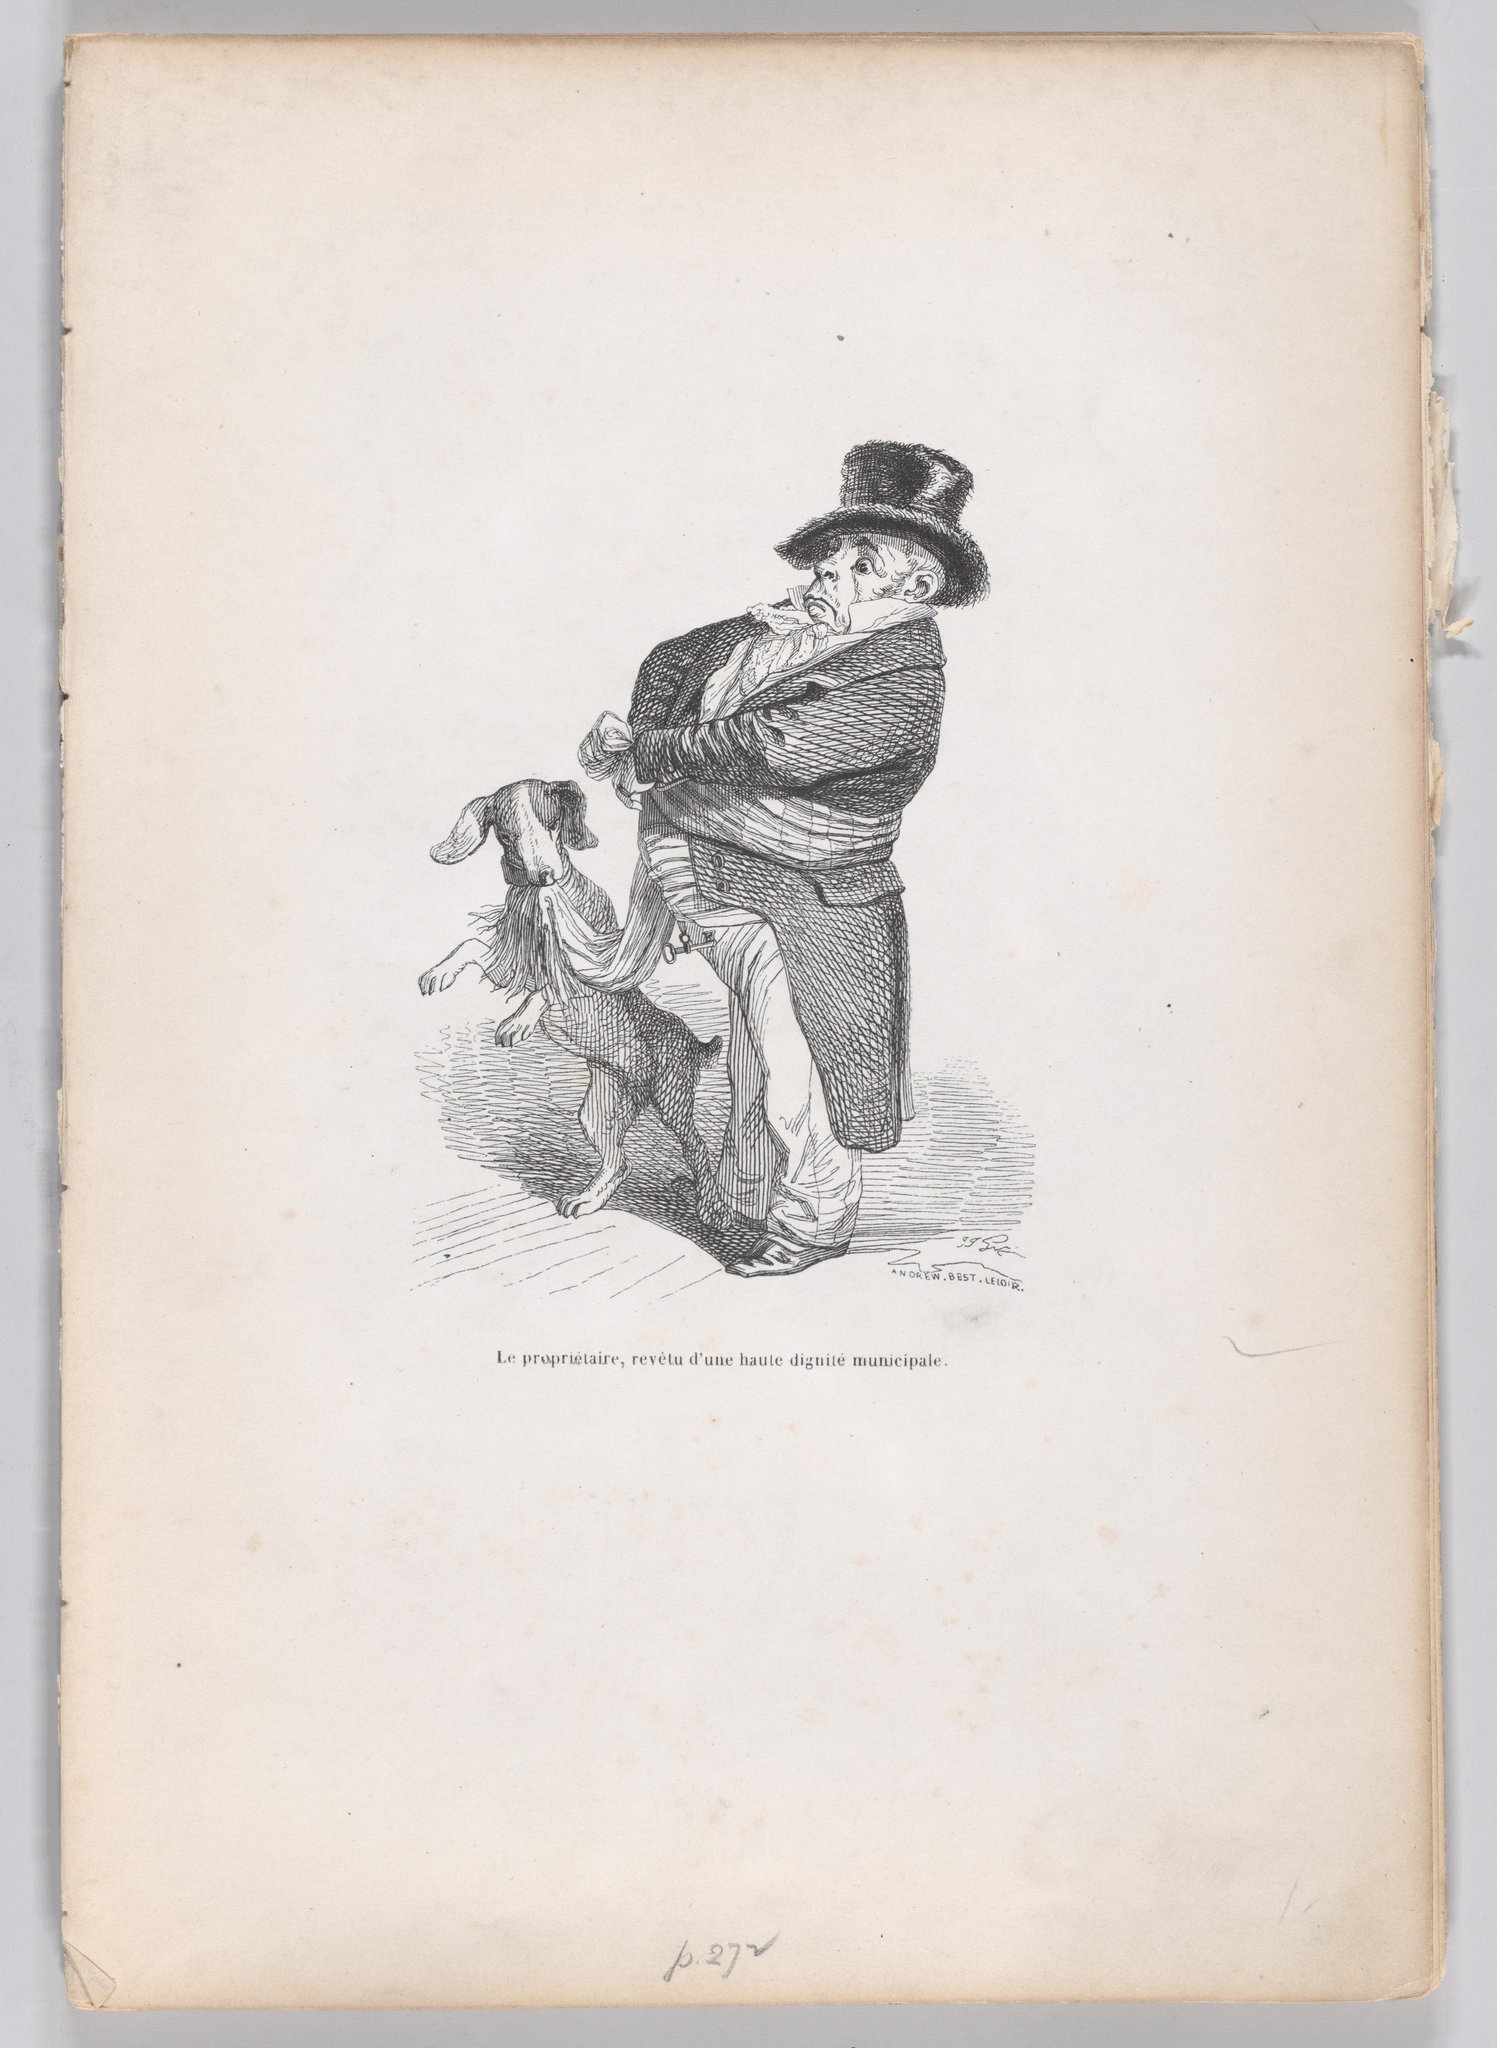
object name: print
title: The Proprietor, from "Scenes from the Private and Public Life of Animals"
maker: j. j. grandville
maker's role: illustrator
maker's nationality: french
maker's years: 1803-1847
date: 1837-1847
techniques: engraving